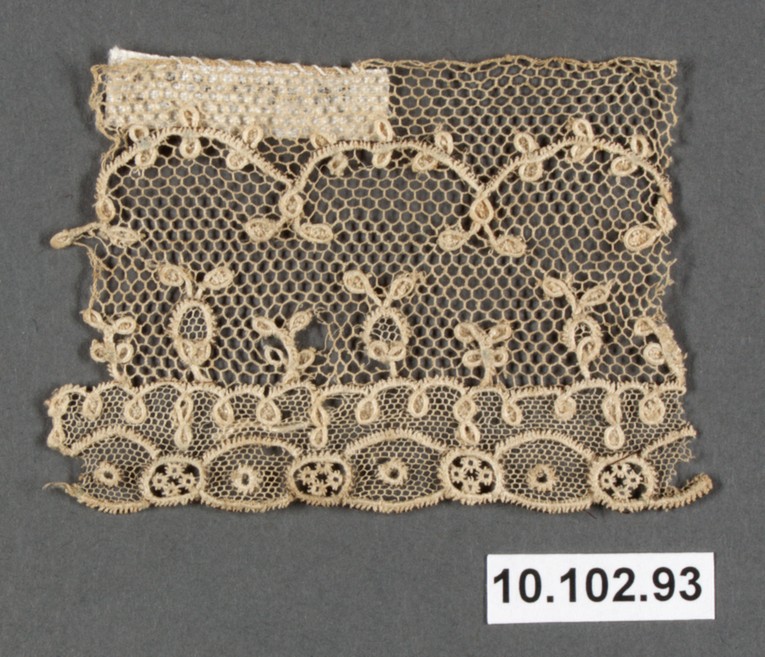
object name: fragment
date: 1801-1900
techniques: lace